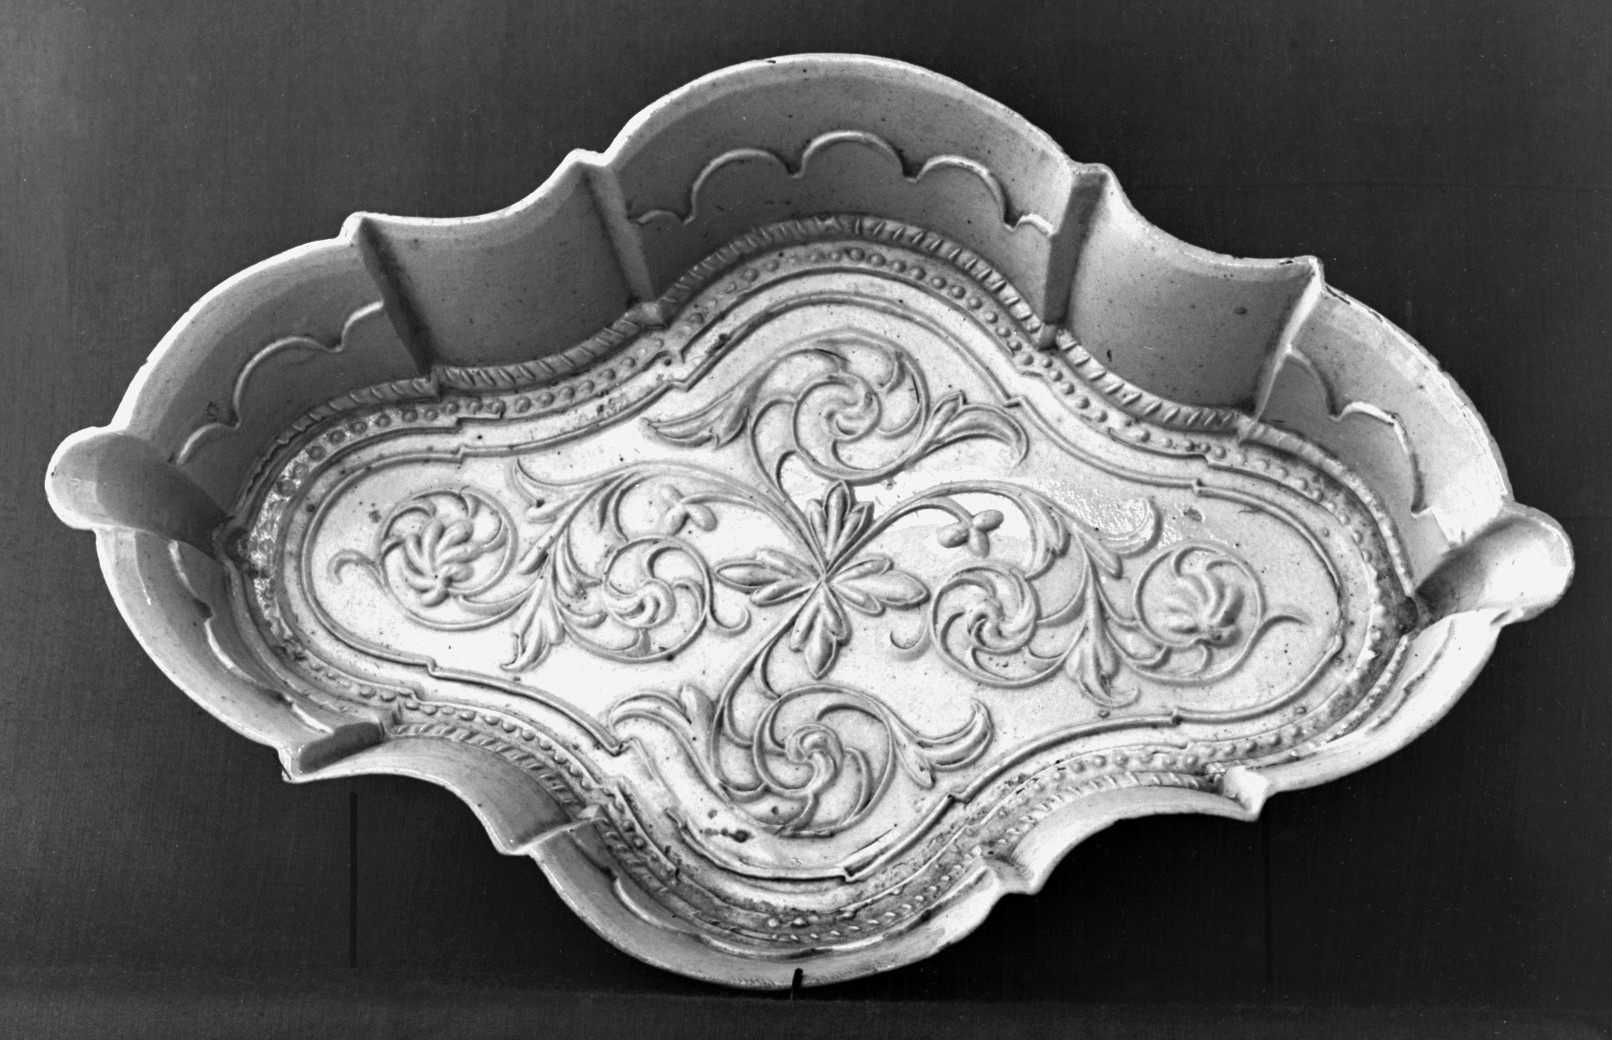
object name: spoon tray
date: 1750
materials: stoneware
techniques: salt glaze